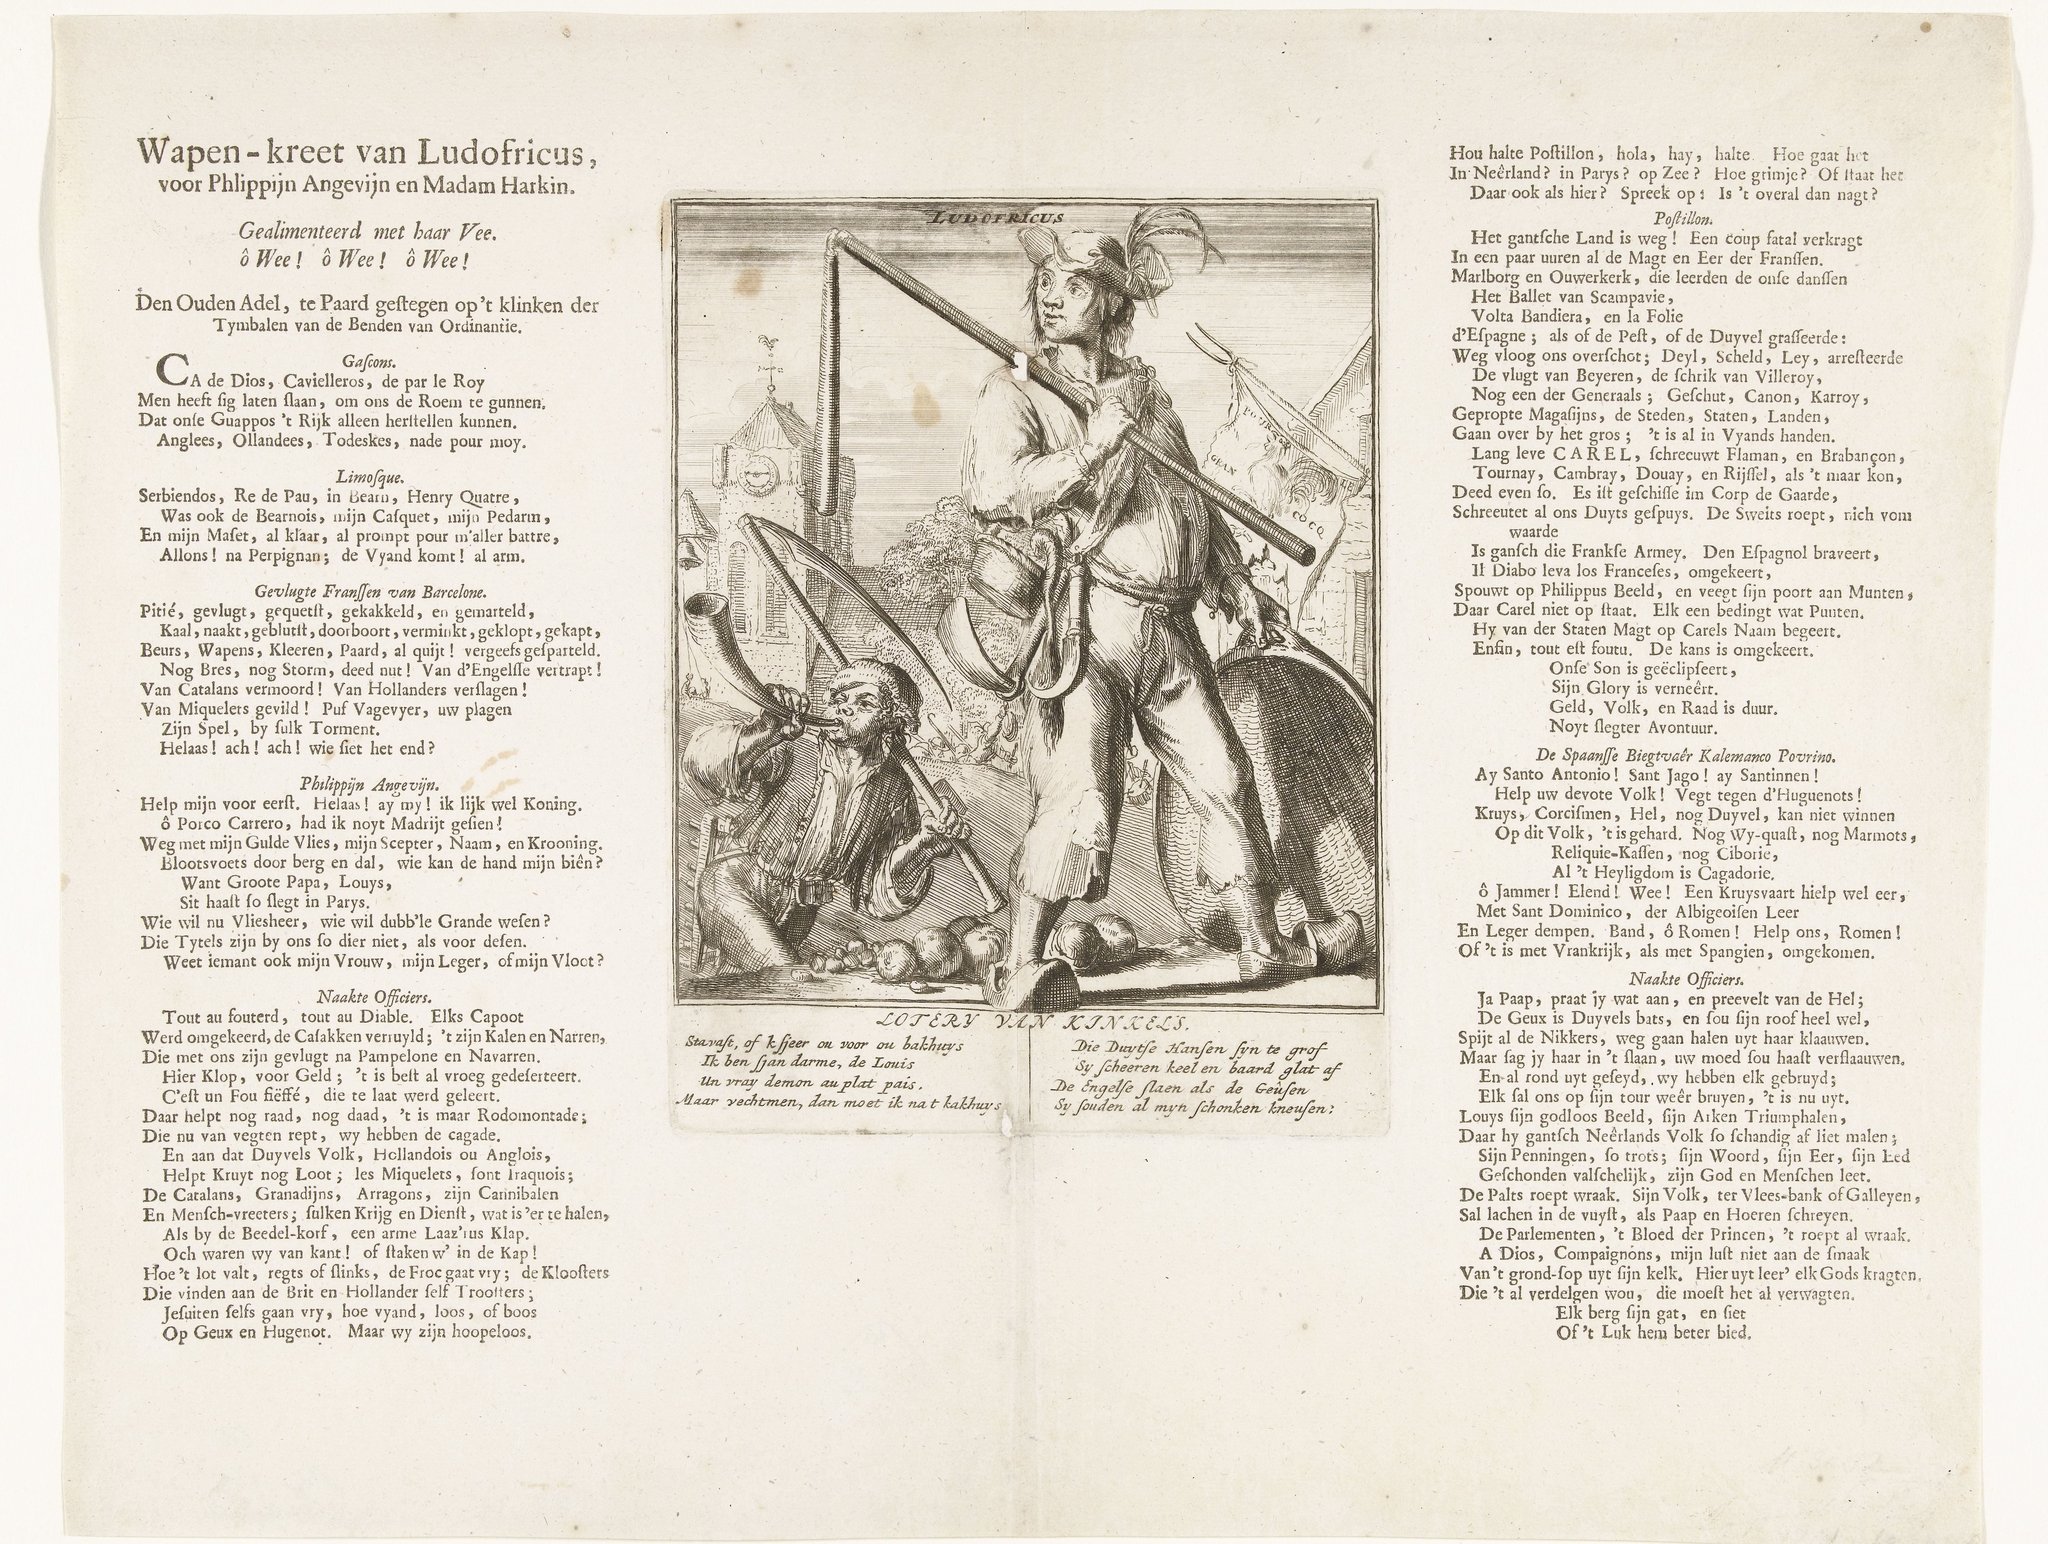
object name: print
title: Spotprent op de Franse boerensoldaten, 1706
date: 1706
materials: paper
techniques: etching, letterpress printing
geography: amsterdam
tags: filips v (koning van spanje), farmers, political caricatures and satires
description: Spotprent op de Franse boerensoldaten die als het op vechten aankomt vluchten naar het kakhuis. Staande Franse boer met vlegel en wan, achter hem blaast een boer met een zeis op een hoorn. In het onderschrift een vers van twee keer vier regels in het Nederlands. Op het blad onder en naast de plaat verzen gedrukt in het Nederlands. Onderdeel van een reeks van 19 spotprenten op de Fransen en bondgenoten uit het jaar 1706.